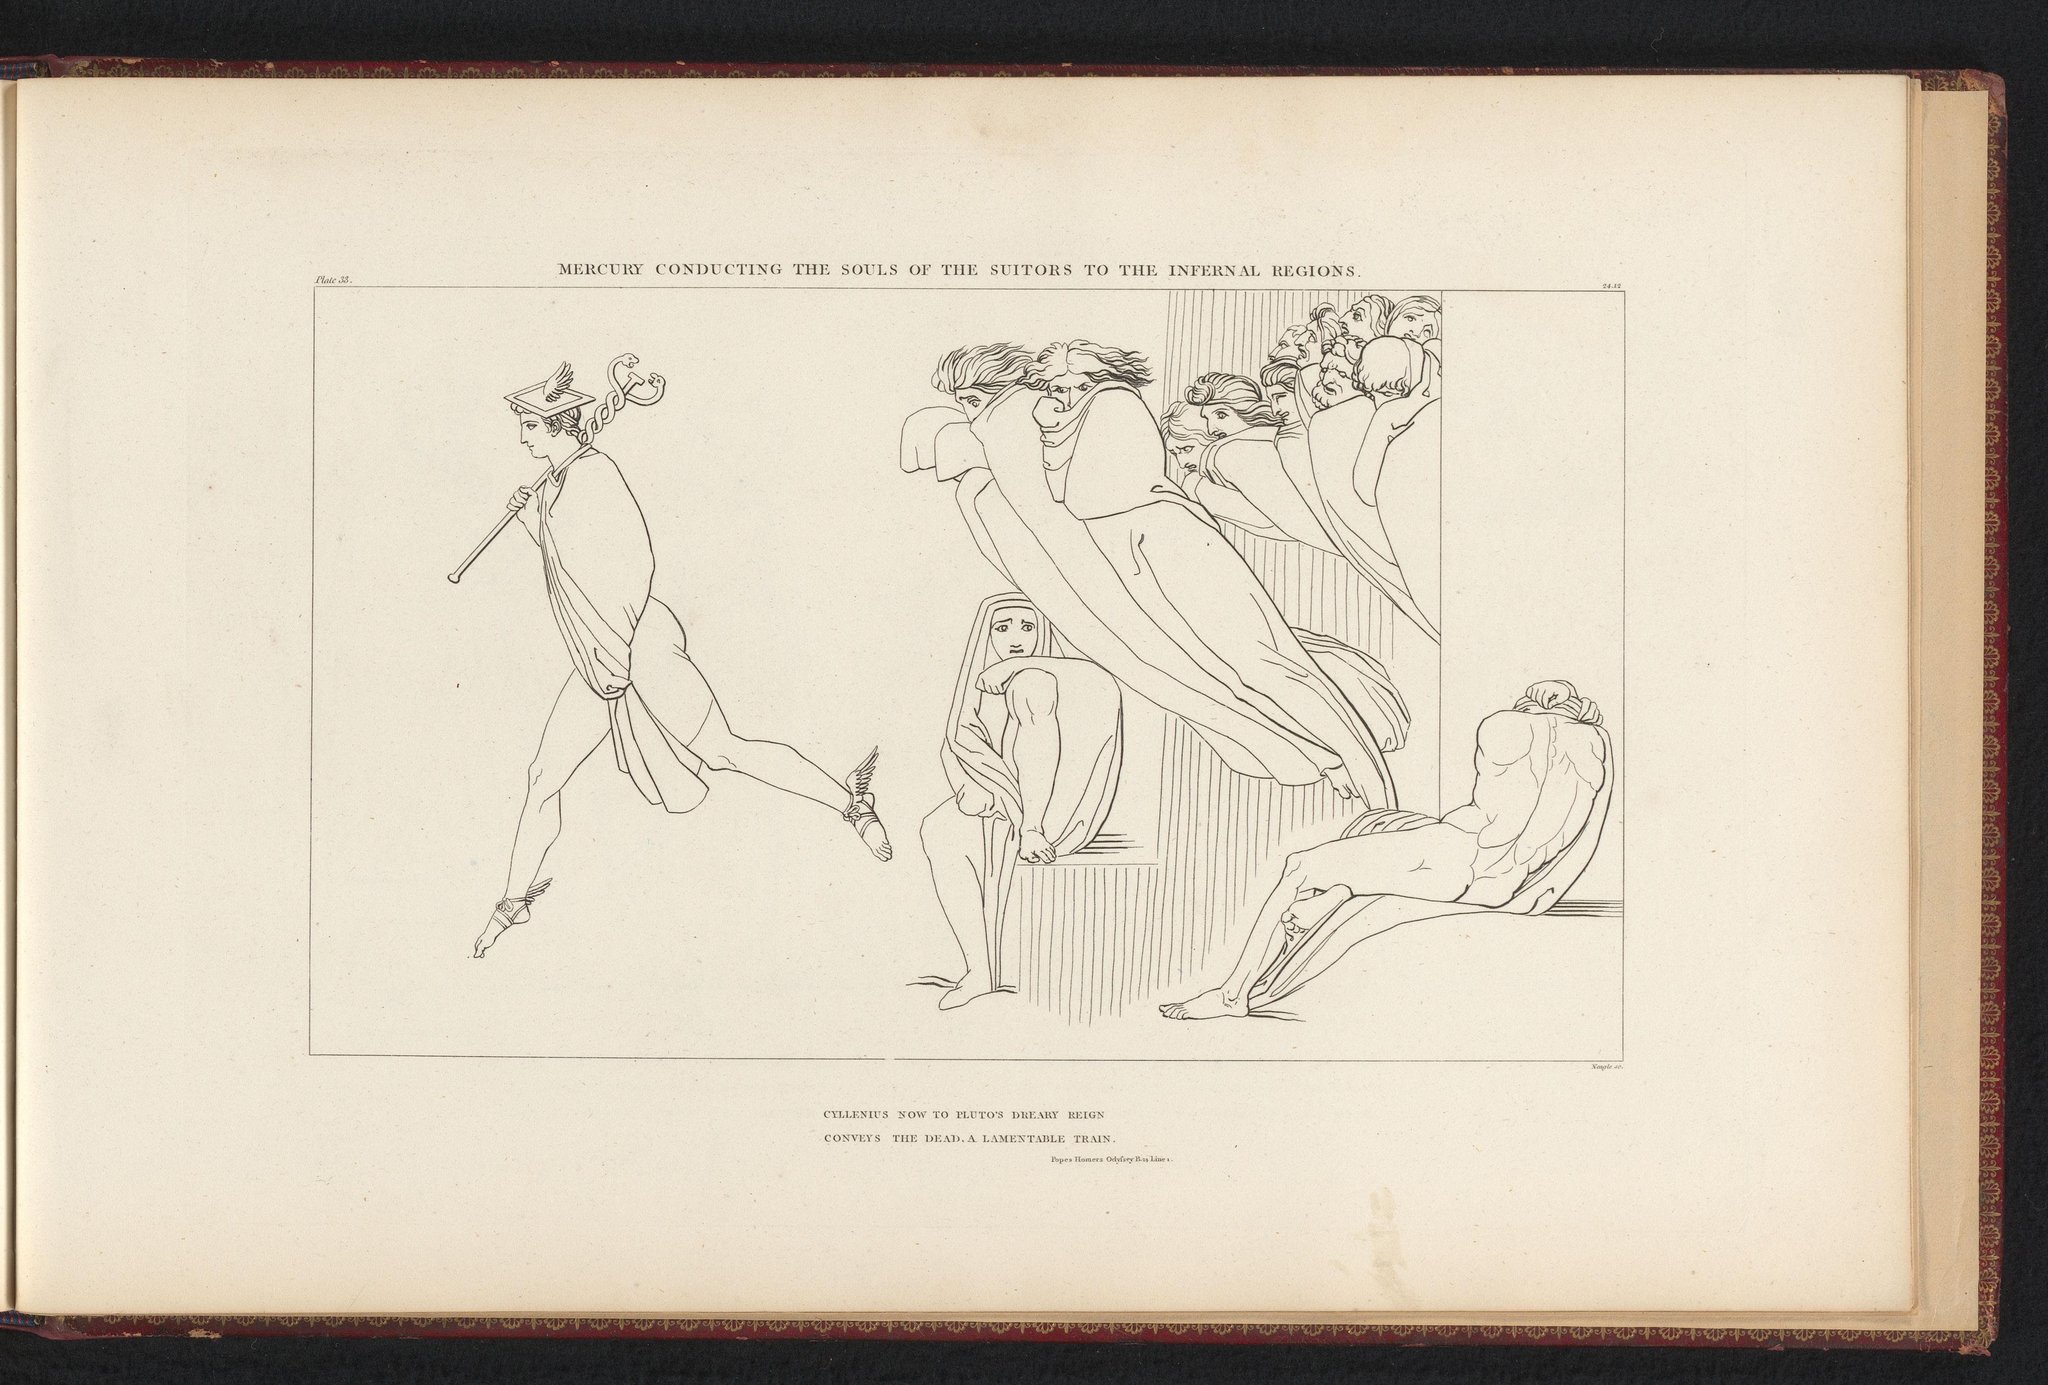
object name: album leaf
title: Odyssey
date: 1805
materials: paper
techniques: etching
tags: mercury brings the souls of the suitors to hades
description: Prent maakt onderdeel uit van een serie met 34 prenten over de Odyssee, geschreven door Homerus.